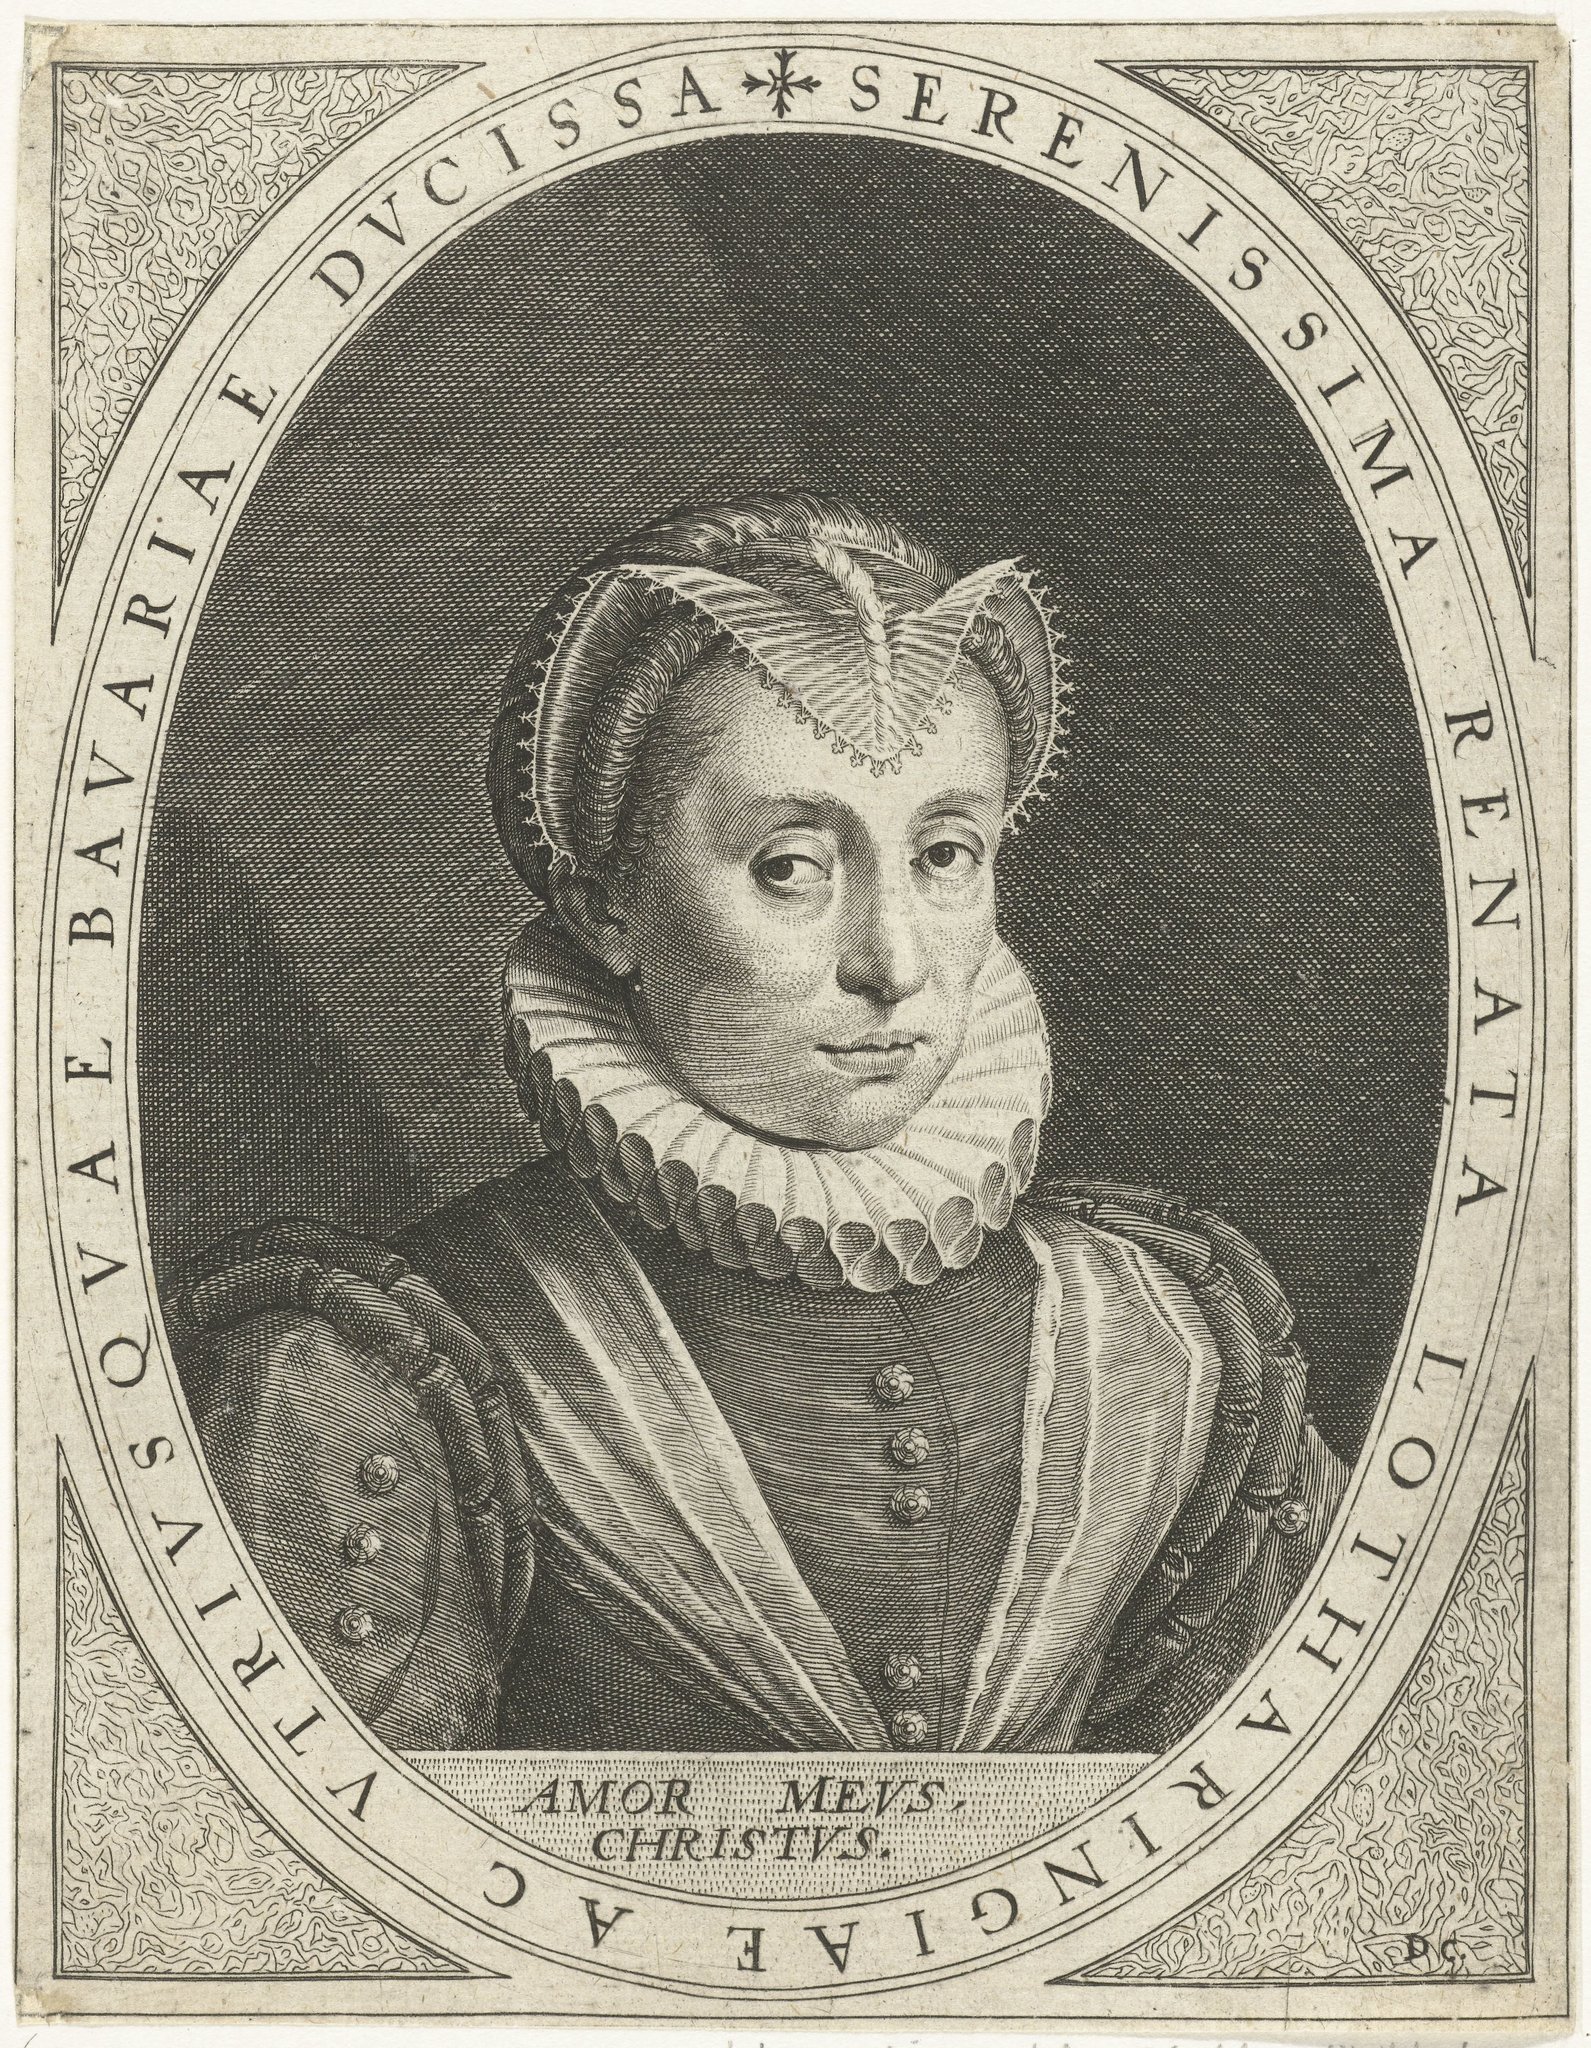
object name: print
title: Portret van Renata van Lotharingen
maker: dominicus custos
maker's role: print maker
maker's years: 1560-1615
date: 1579-1615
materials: paper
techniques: engraving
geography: augsburg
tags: renata van lotharingen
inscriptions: collector's mark: Lugt 2228, collector's mark: Lugt 2760